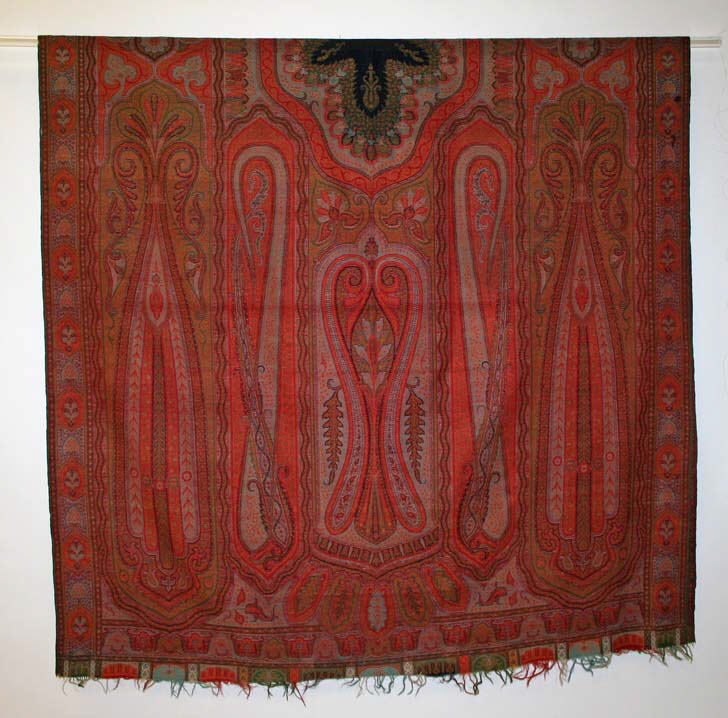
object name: shawl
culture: european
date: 1850-1869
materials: wool